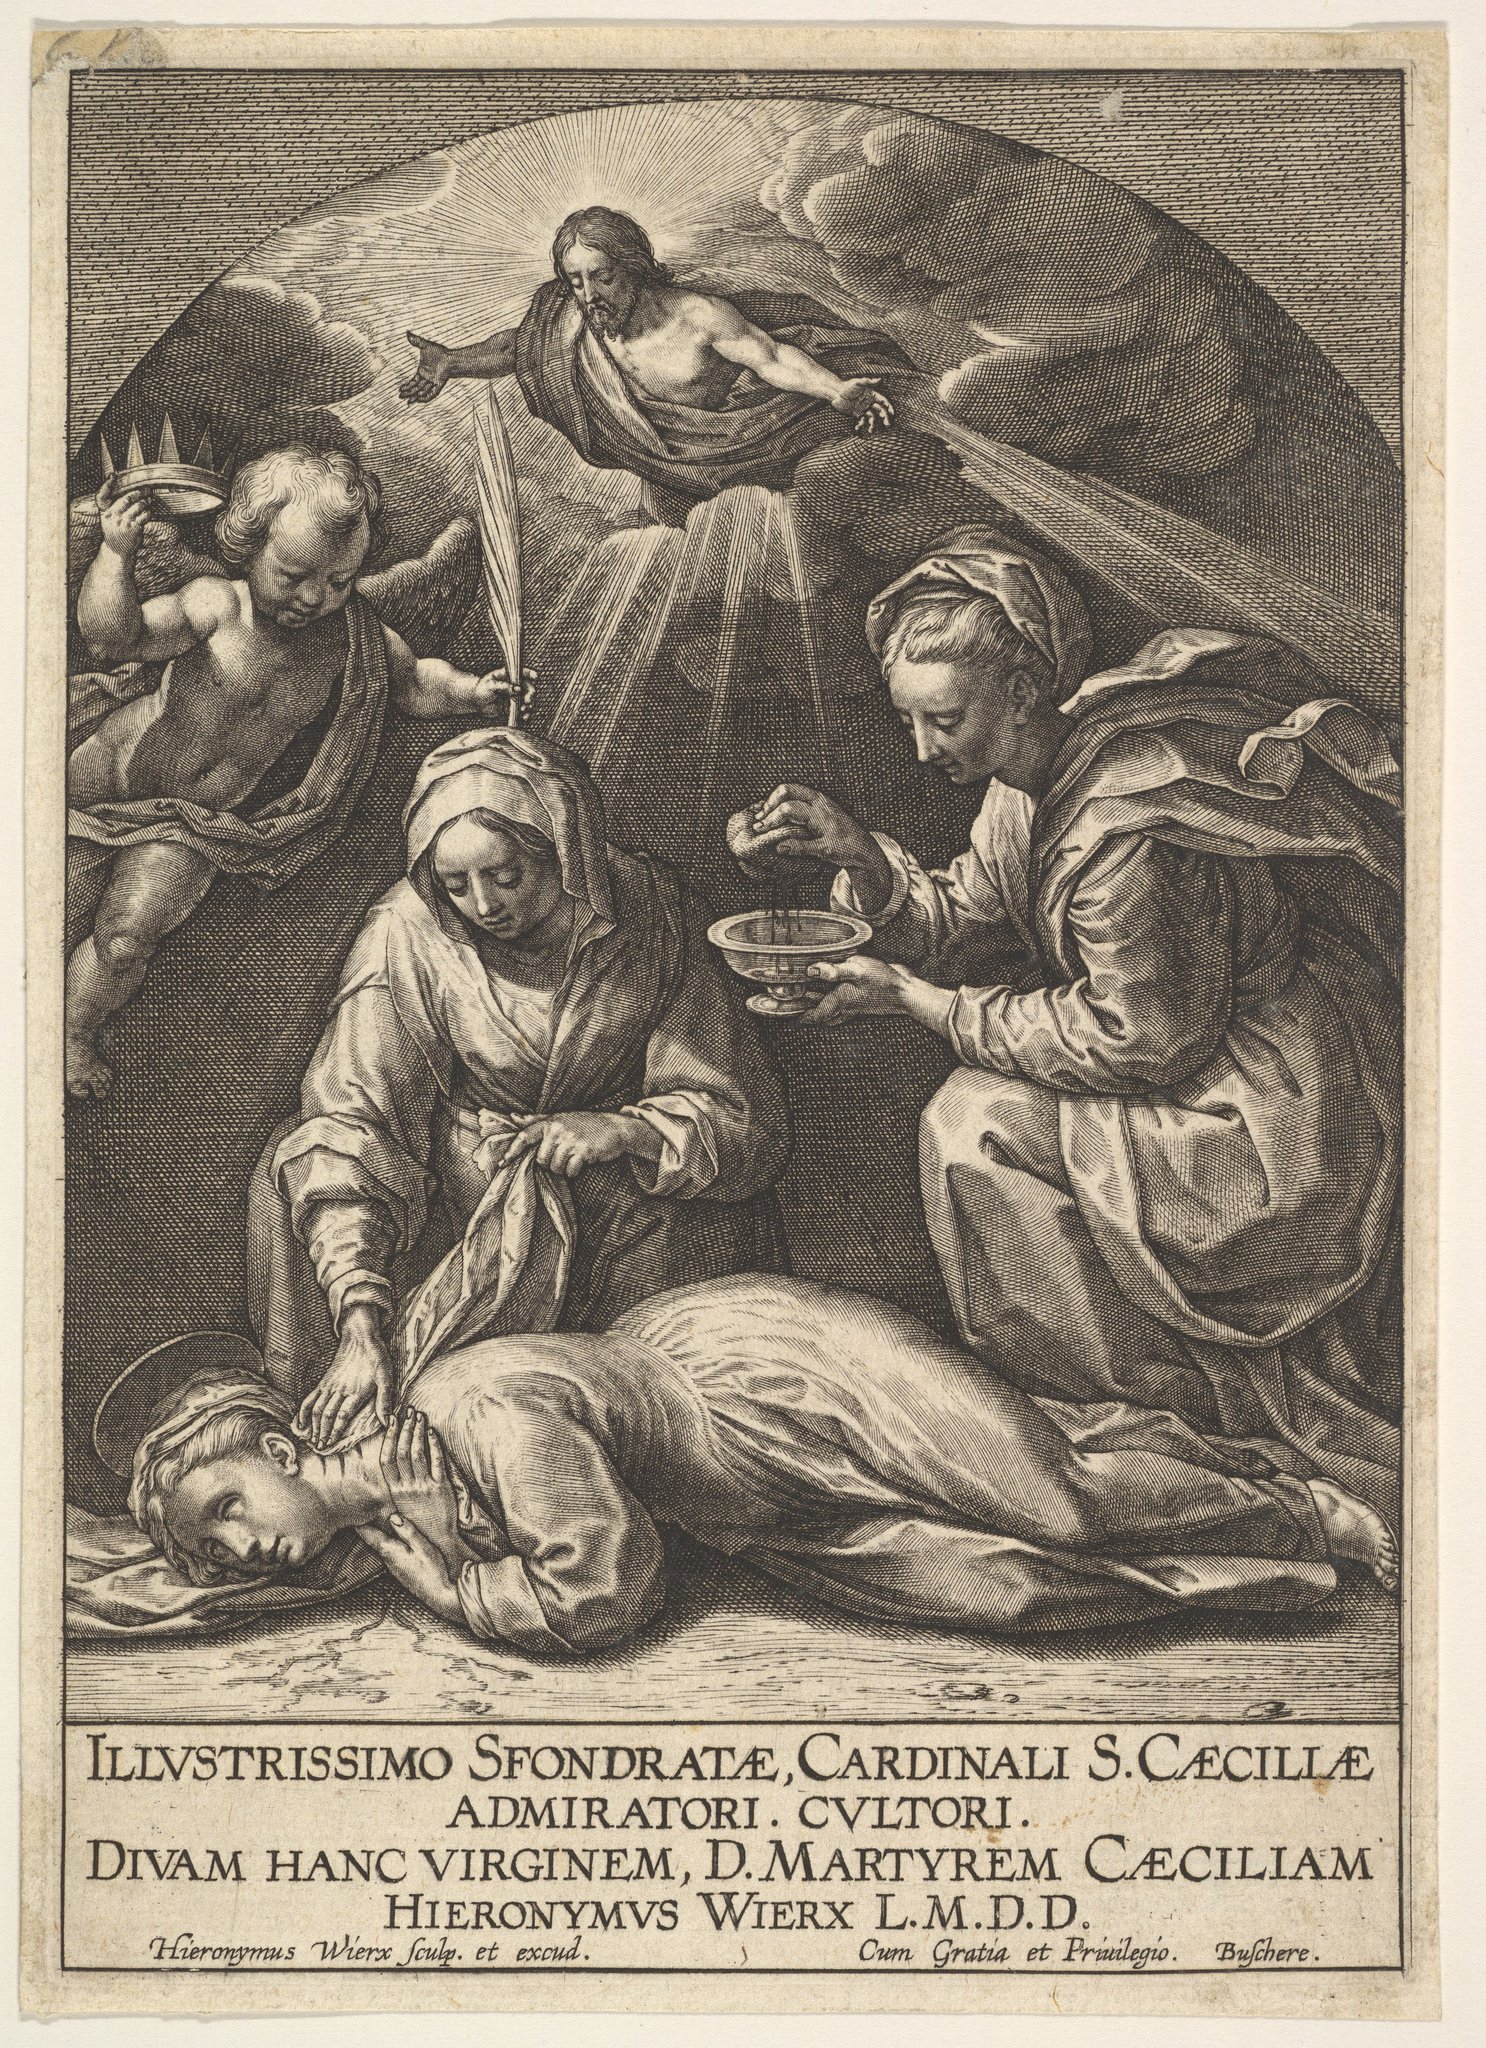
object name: print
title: Death of St. Cecilia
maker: hieronymus wierix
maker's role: artist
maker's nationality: netherlandish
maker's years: 1553-1619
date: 1599-1605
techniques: engraving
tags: women,angels,christ,saints,death